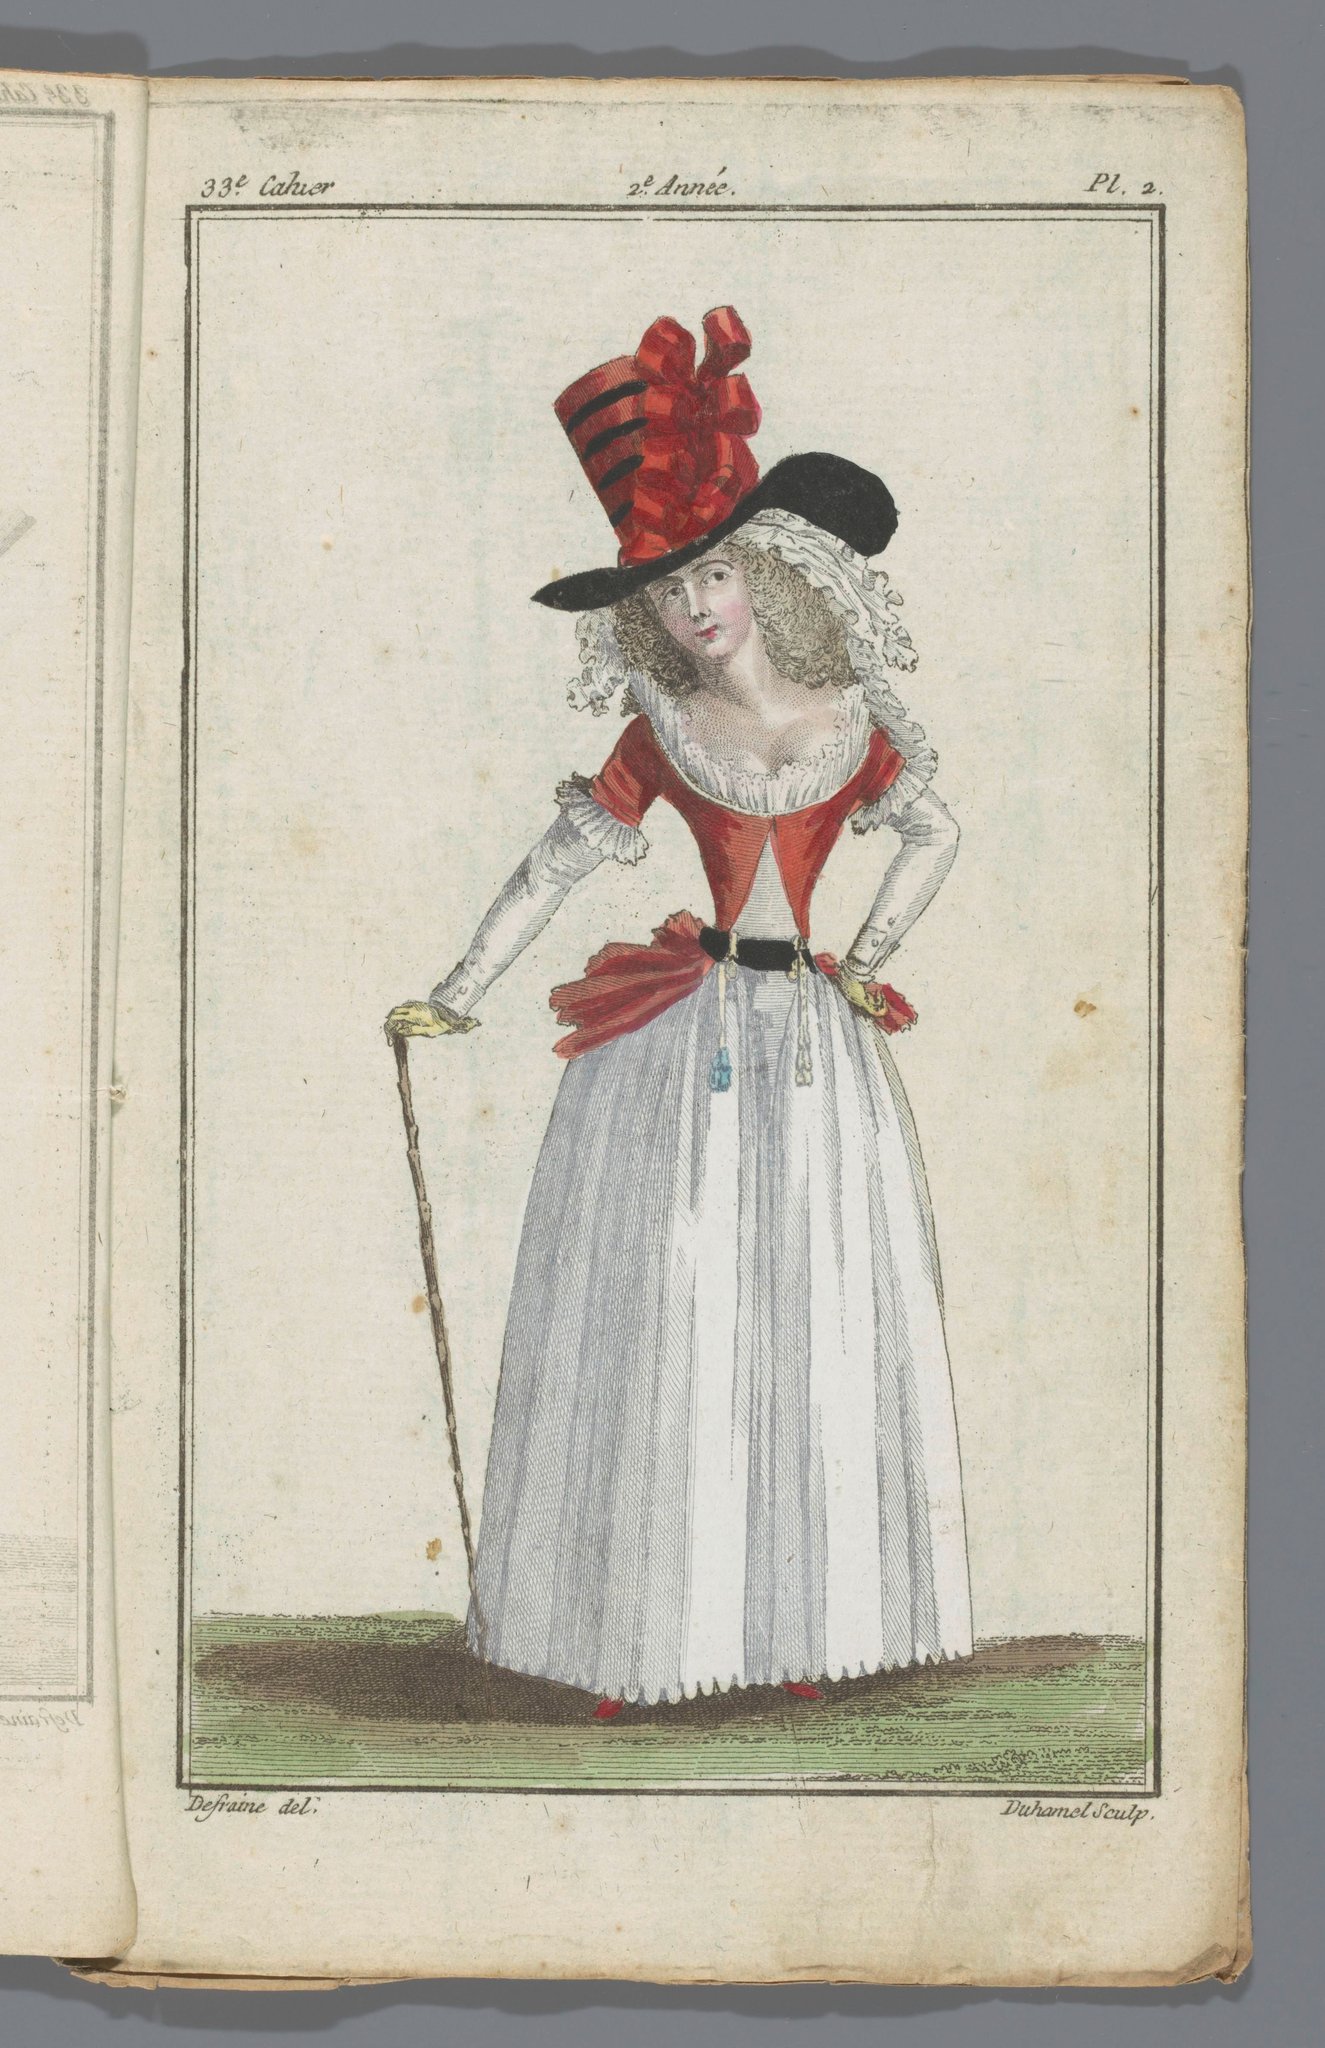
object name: fashion print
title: Magasin des Modes Nouvelles Françaises et Anglaises, 10 octobre 1787, 33e cahier, 2e année, Pl. 2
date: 1787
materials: paper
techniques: engraving, hand coloring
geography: paris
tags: clothing for the upper part of the body (caraco) (+ women's clothes), walking-stick, staff, cane (+ women's clothes), fashion plates, head-gear: hat (+ women's clothes), skirt (+ women's clothes)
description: Staande vrouw gekleed in een rode caraco op een witte rok. Op het hoofd een 'chapeau à la Tarare' (??). Wandelstok van bamboe in de rechterhand. De prent maakt deel uit van het 33e Cahier, 2e année, uit de serie Magasin des Modes Nouvelles Françaises et Anglaises. De serie bestaat uit 172 modeprenten, uitgegeven door Buisson, Parijs, 20 novembre 1786 - 21 décembre 1789.